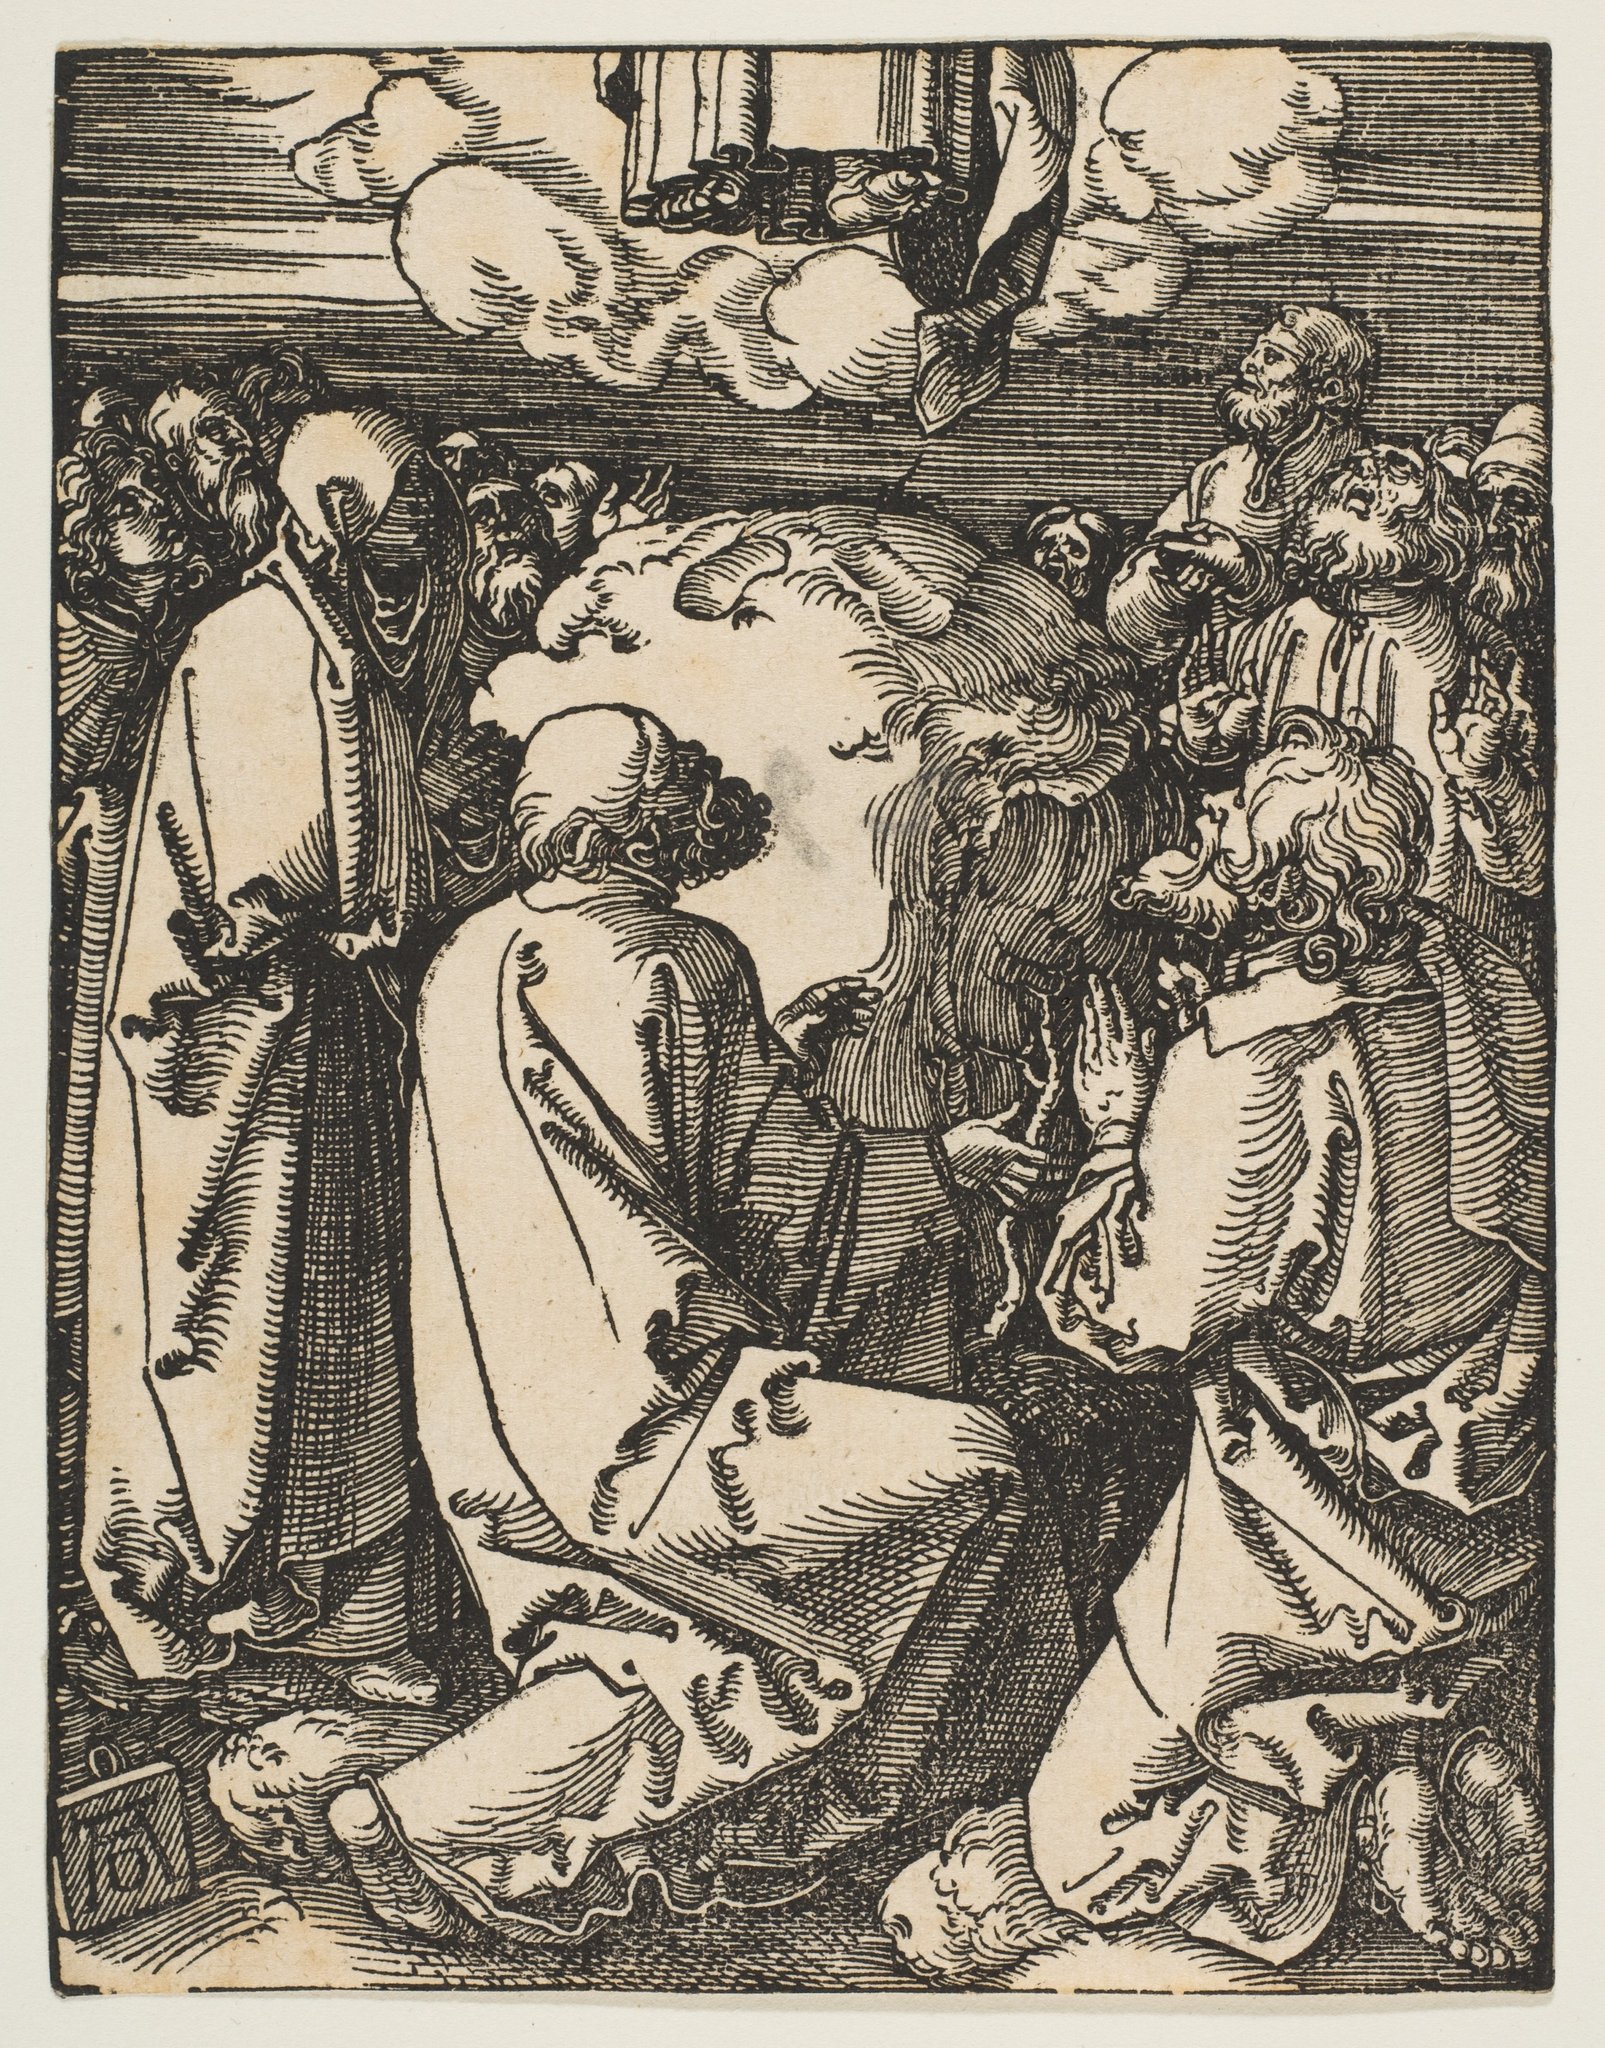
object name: print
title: The Ascension, from "The Small Passion"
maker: albrecht dürer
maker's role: artist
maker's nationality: german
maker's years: 1471-1528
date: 1510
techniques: woodcut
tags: men